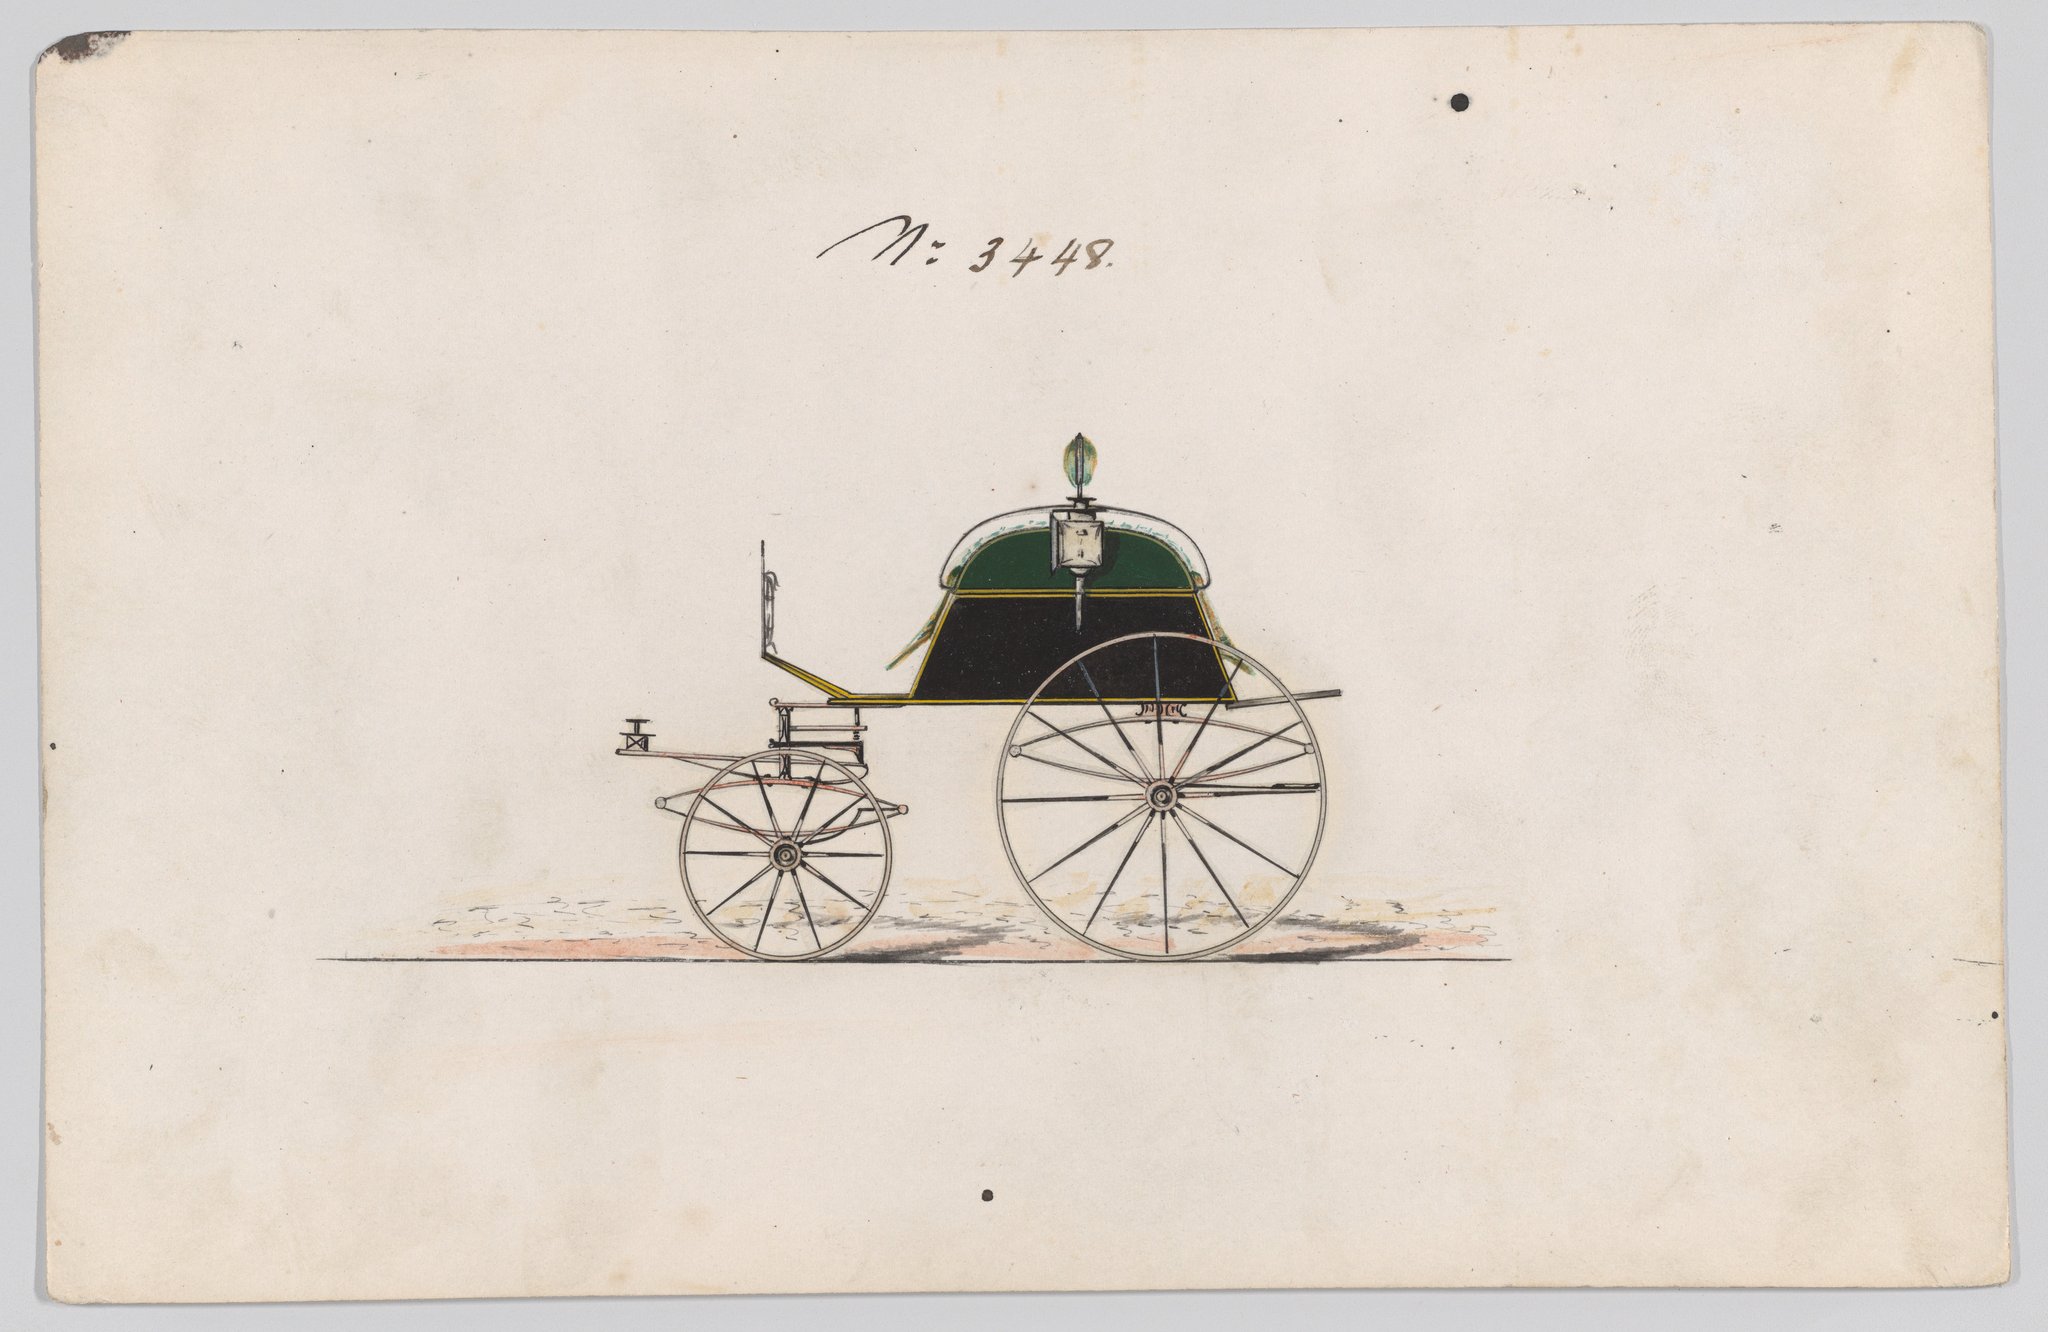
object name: drawing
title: Crescent Cart #3448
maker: brewster & co.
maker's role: manufacturer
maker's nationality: american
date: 1878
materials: gum arabic, ink, watercolor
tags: carriages